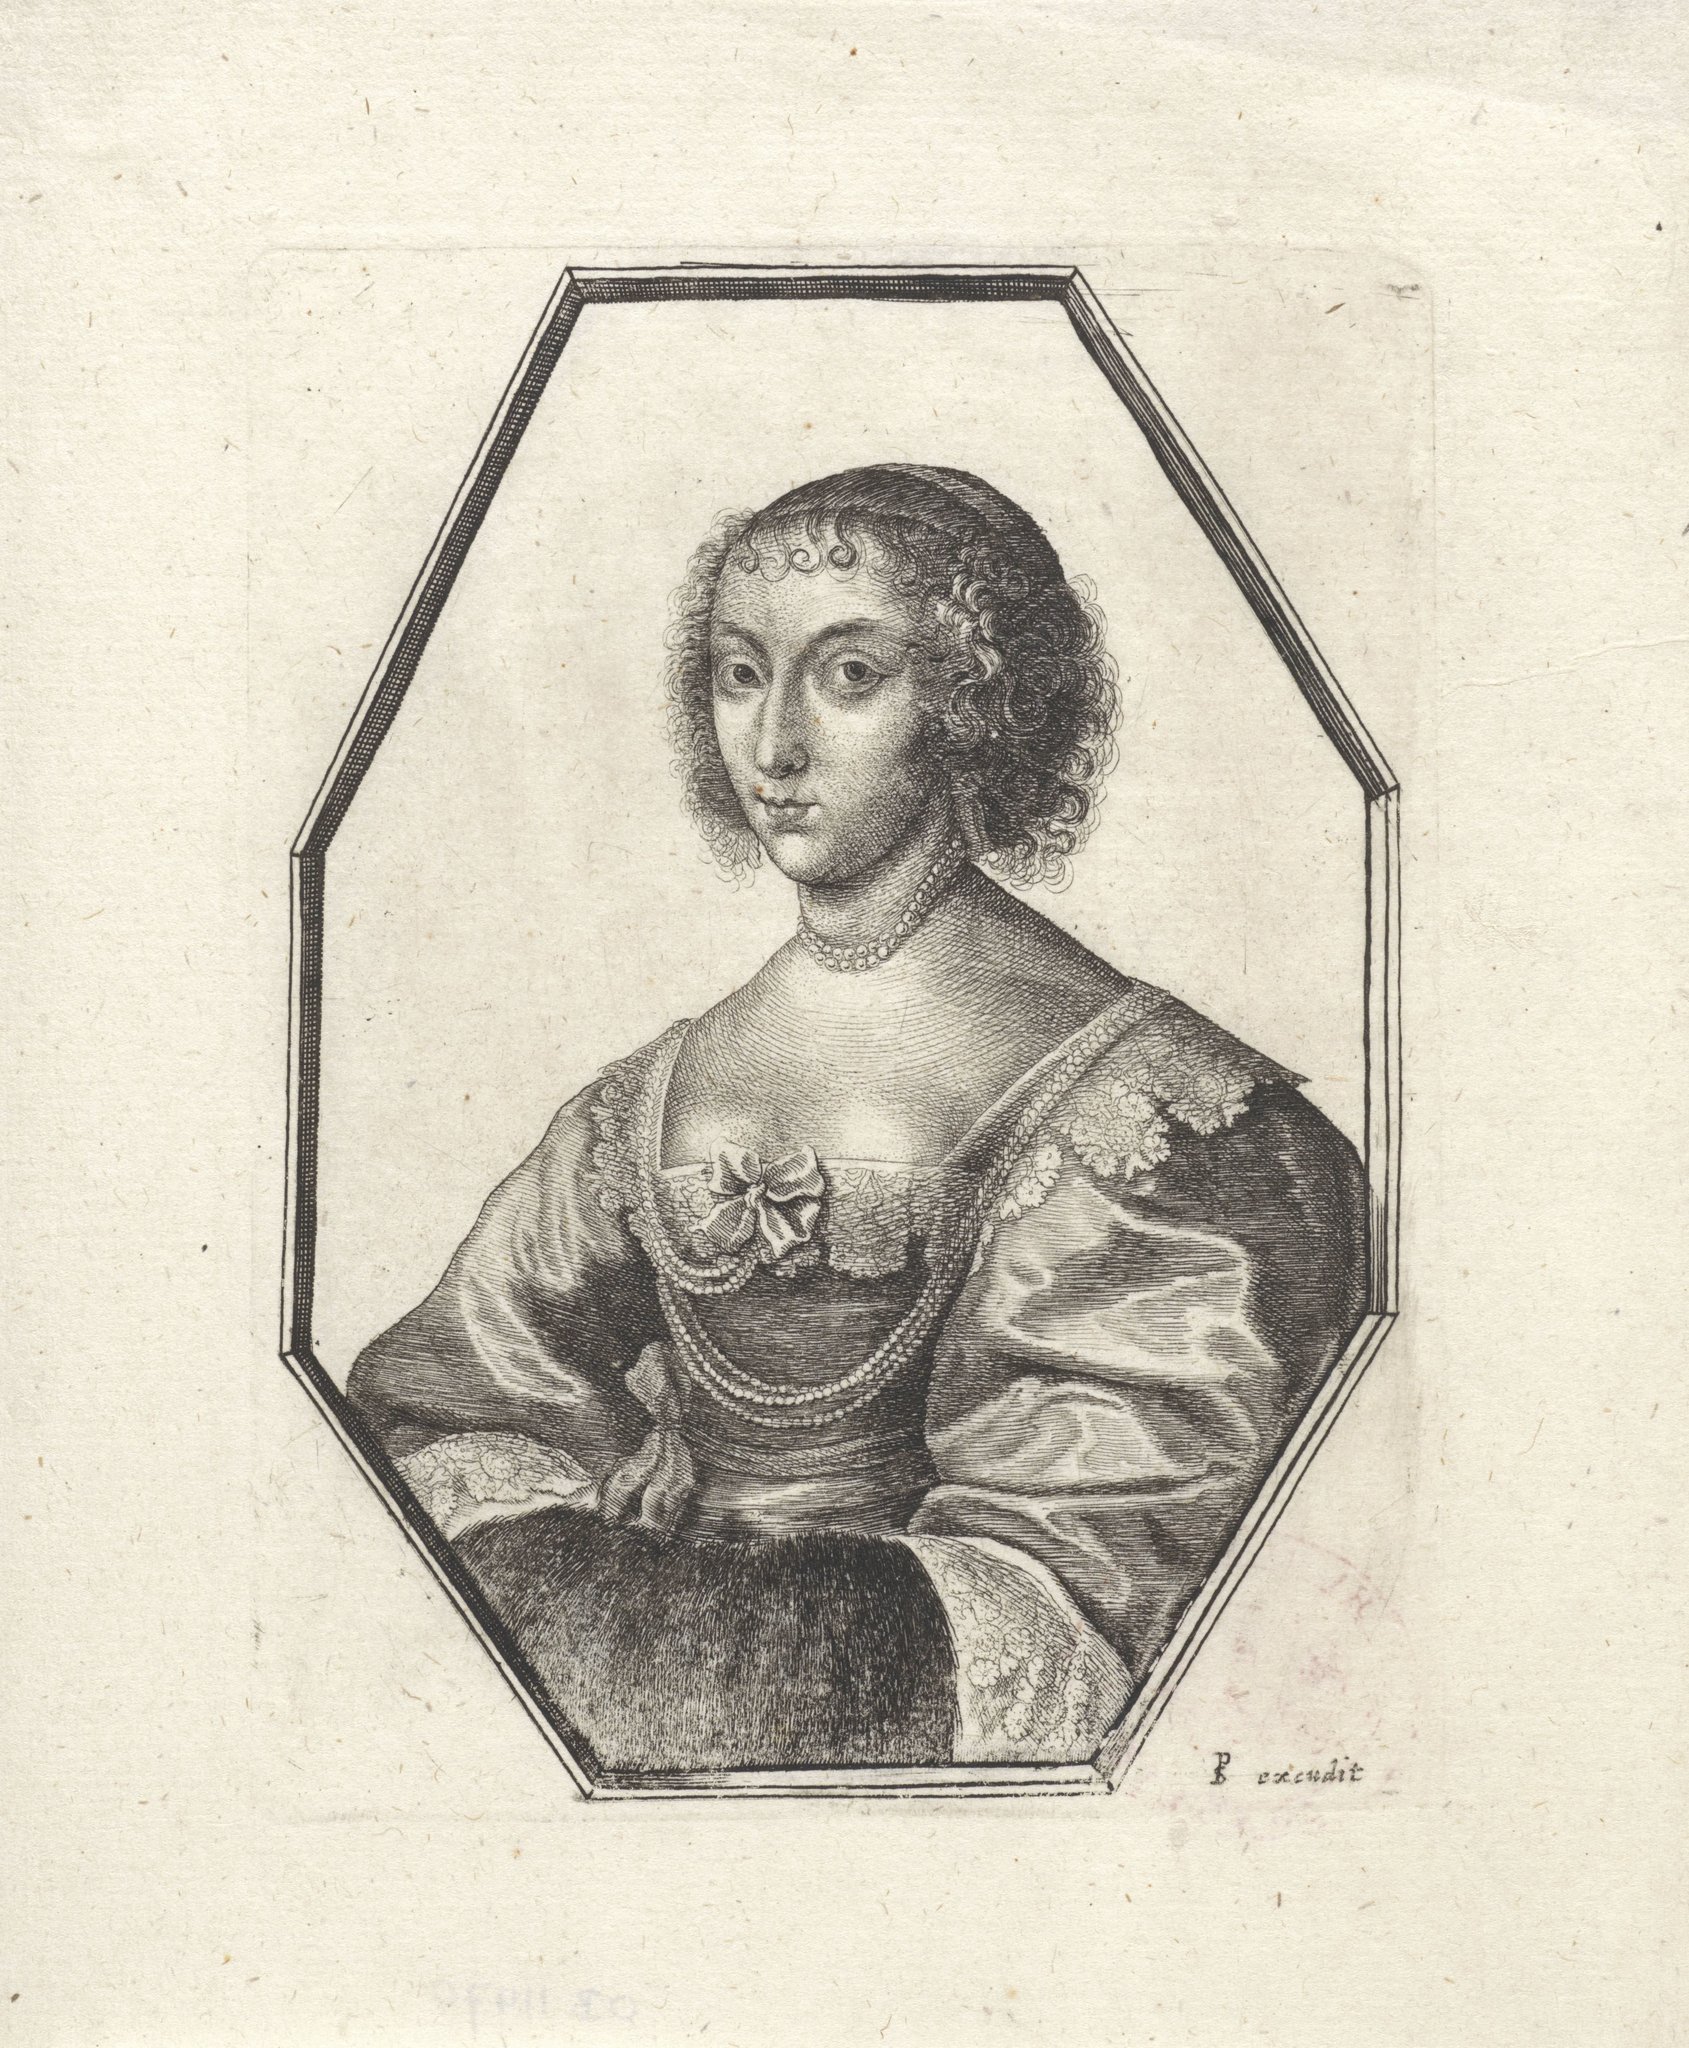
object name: print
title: Vrouwenportretten in achthoekige lijsten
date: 1637-1638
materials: paper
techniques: etching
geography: london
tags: muff, anonymous historical person portrayed alone - bb - woman, pearl; pearl necklace (+ women's clothes)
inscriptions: collector's mark: Lugt 240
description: De prent maakt deel uit van een zesdelige serie met vrouwenportretten in achthoekige lijsten.